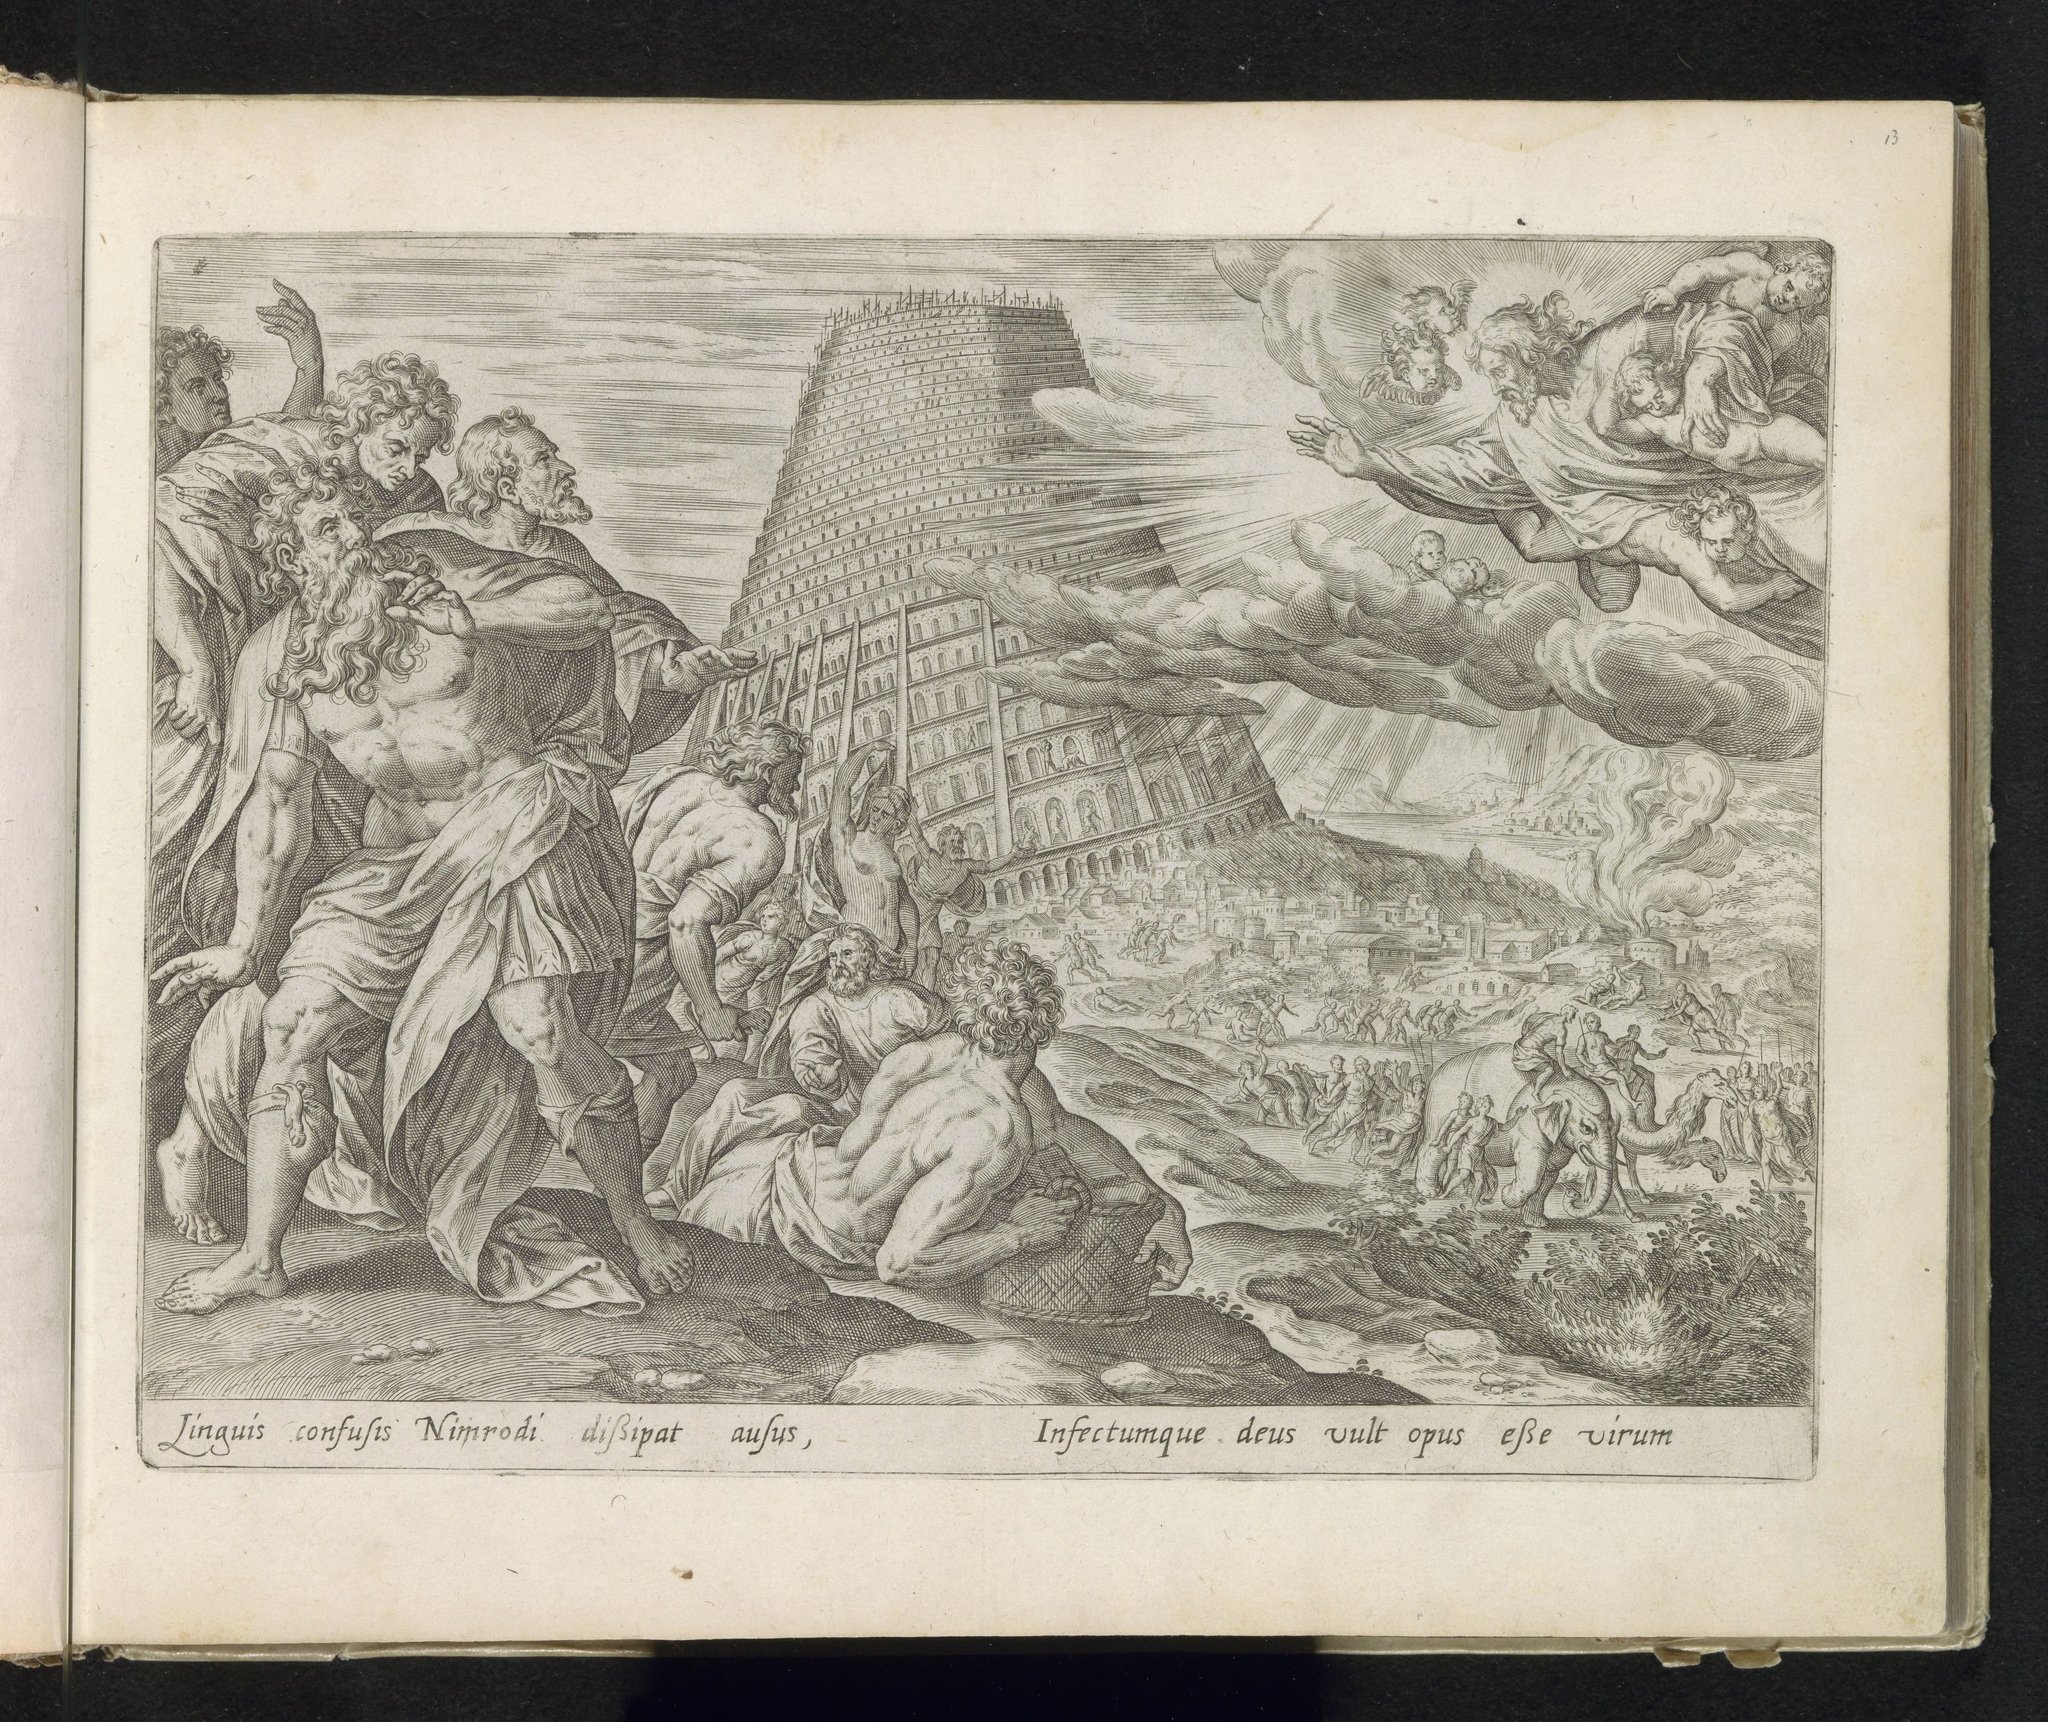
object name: album leaf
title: Geschiedenis van de toren van Babel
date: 1585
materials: paper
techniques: engraving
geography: antwerp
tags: the confusion of languages and the scattering of people over the earth ~ story of the tower of babel, god the father represented as human being, usually with crown or tiara or sceptre and/or globe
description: God de Vader verschijnt, omringd door cherubijnen, aan de hemel bij de toren van Babel. Hij brengt een spraakverwarring teweeg, waardoor de mensen elkaar niet meer kunnen verstaan. De mensen rond de toren vluchten alle kanten op. Een aantal van hen vlucht op een olifant en op kamelen. Op de voorgrond kijken Nimrod en andere mannen verschrikt toe. Onder de voorstelling een tekst in het Latijn. Deze prent maakt deel uit van een album.